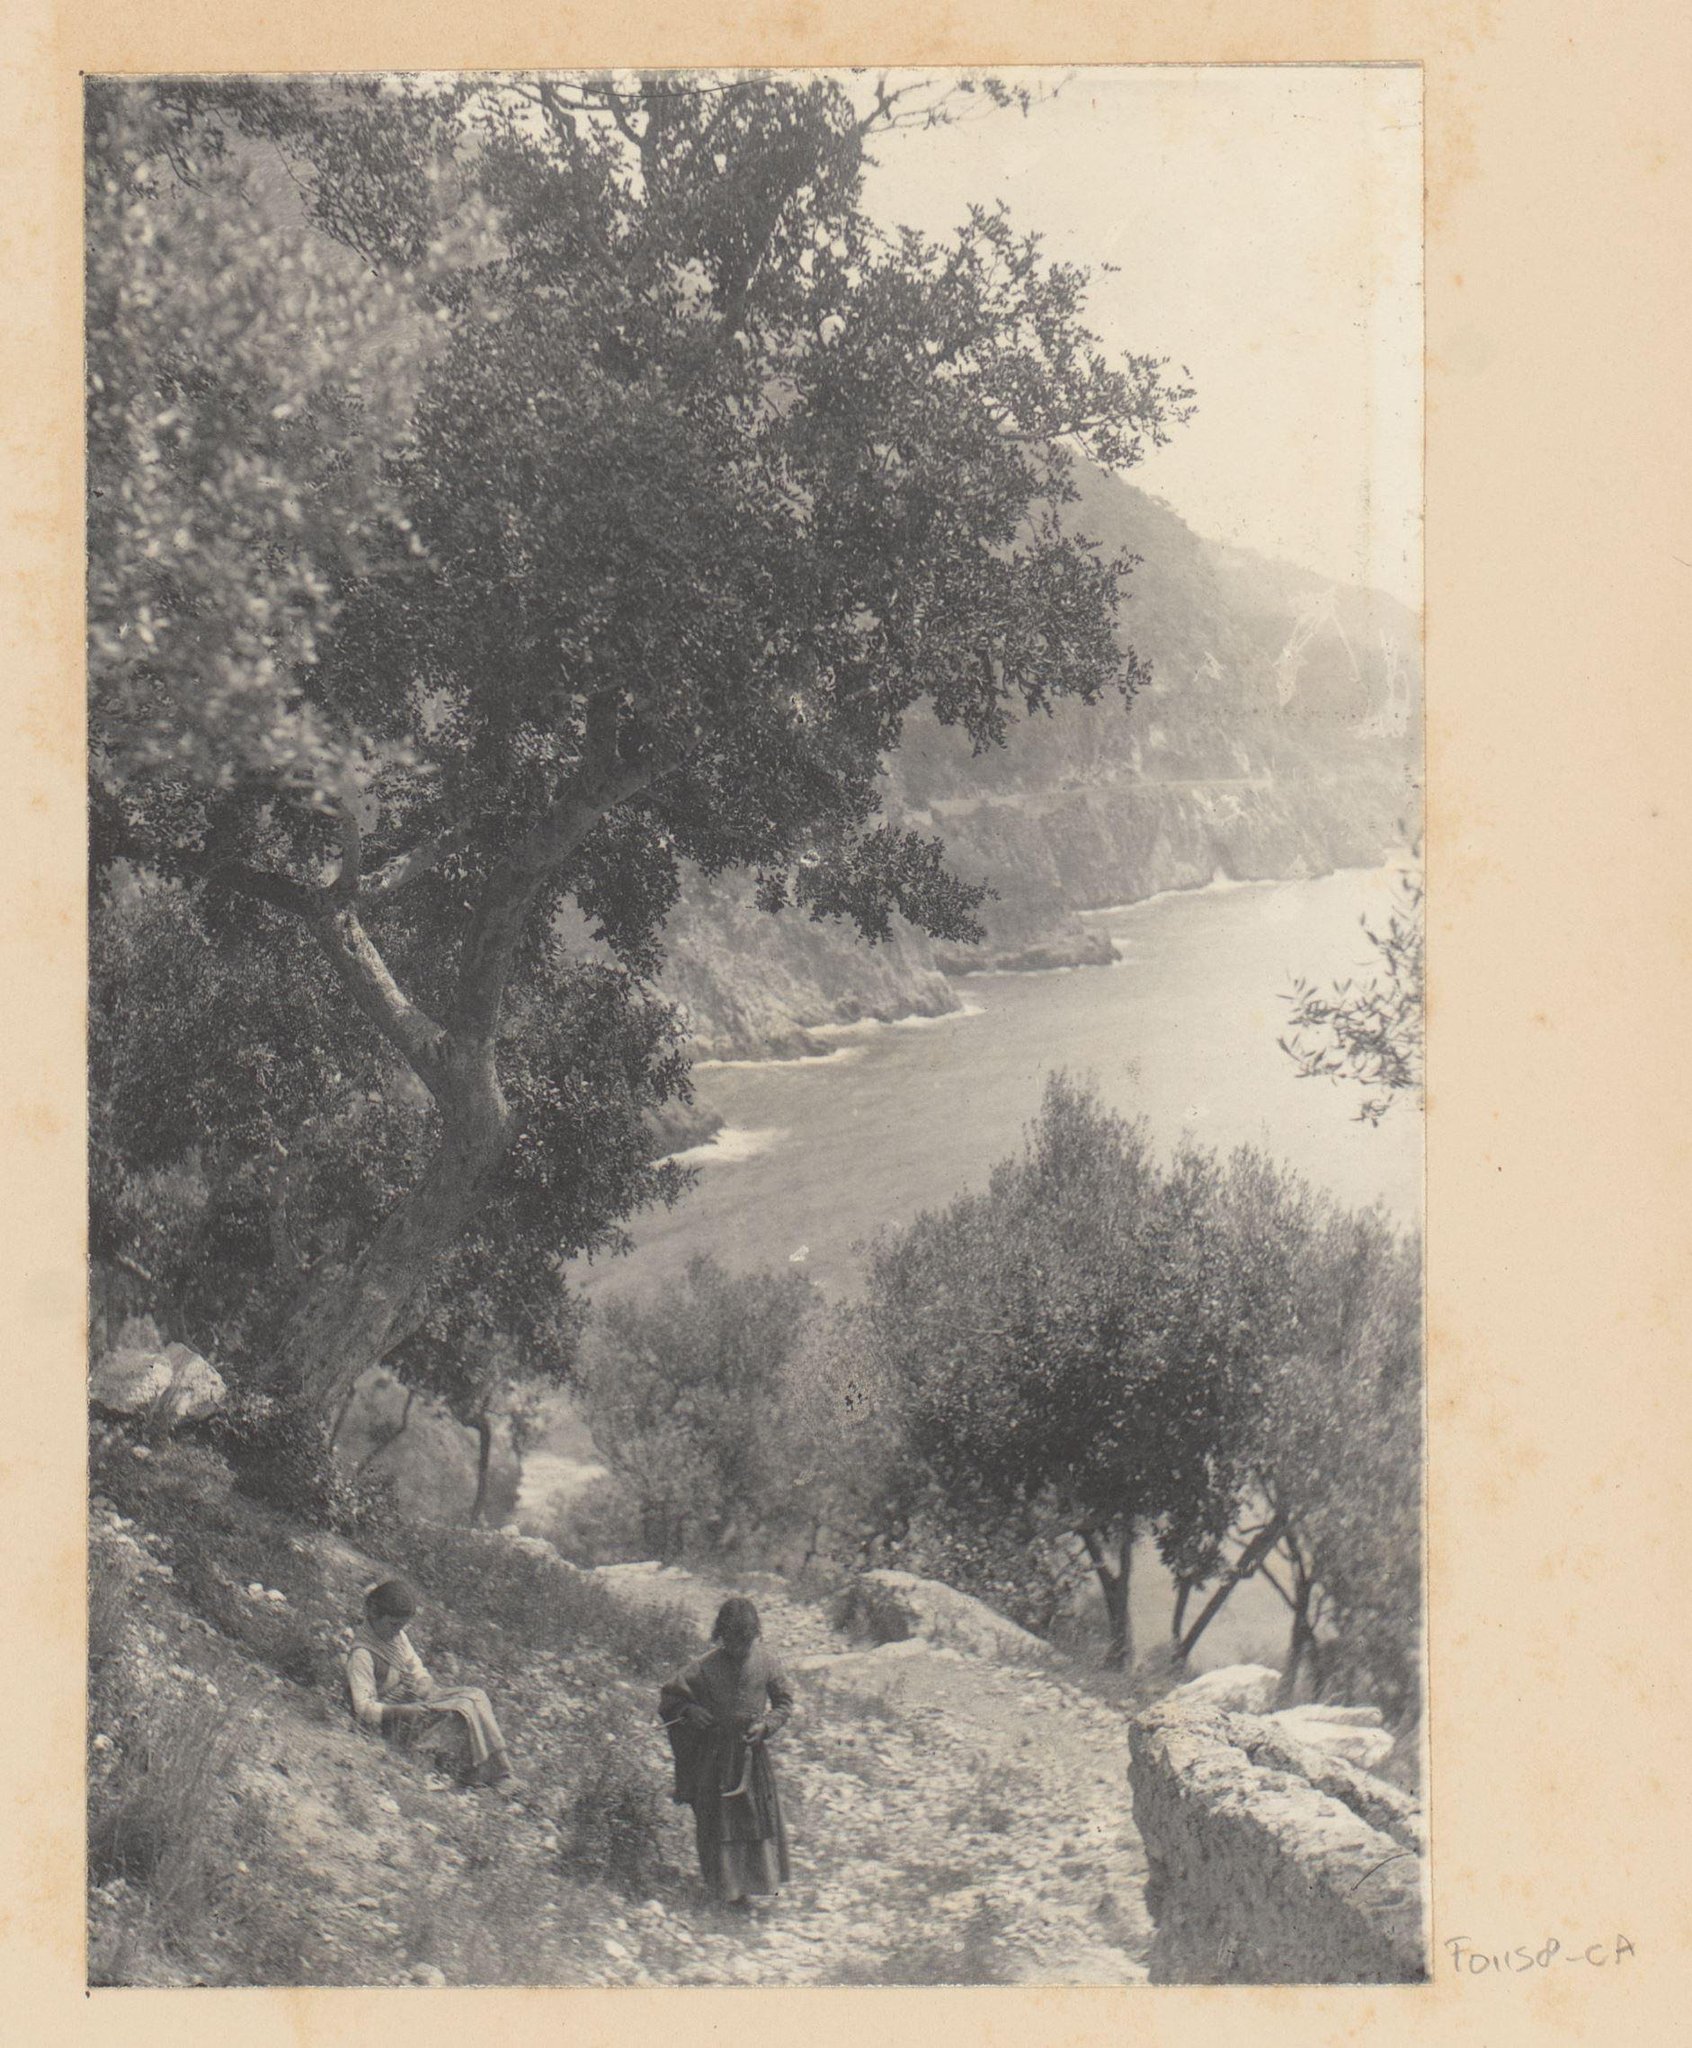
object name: photograph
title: Gezicht op een baai (vermoedelijk) te Italië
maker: Anonymous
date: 1875-1907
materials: photographic support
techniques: platinum process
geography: italy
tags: gulf, bay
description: Onderdeel van Fotoalbum met opnames van bezienswaardigheden en kunstwerken in Italië.